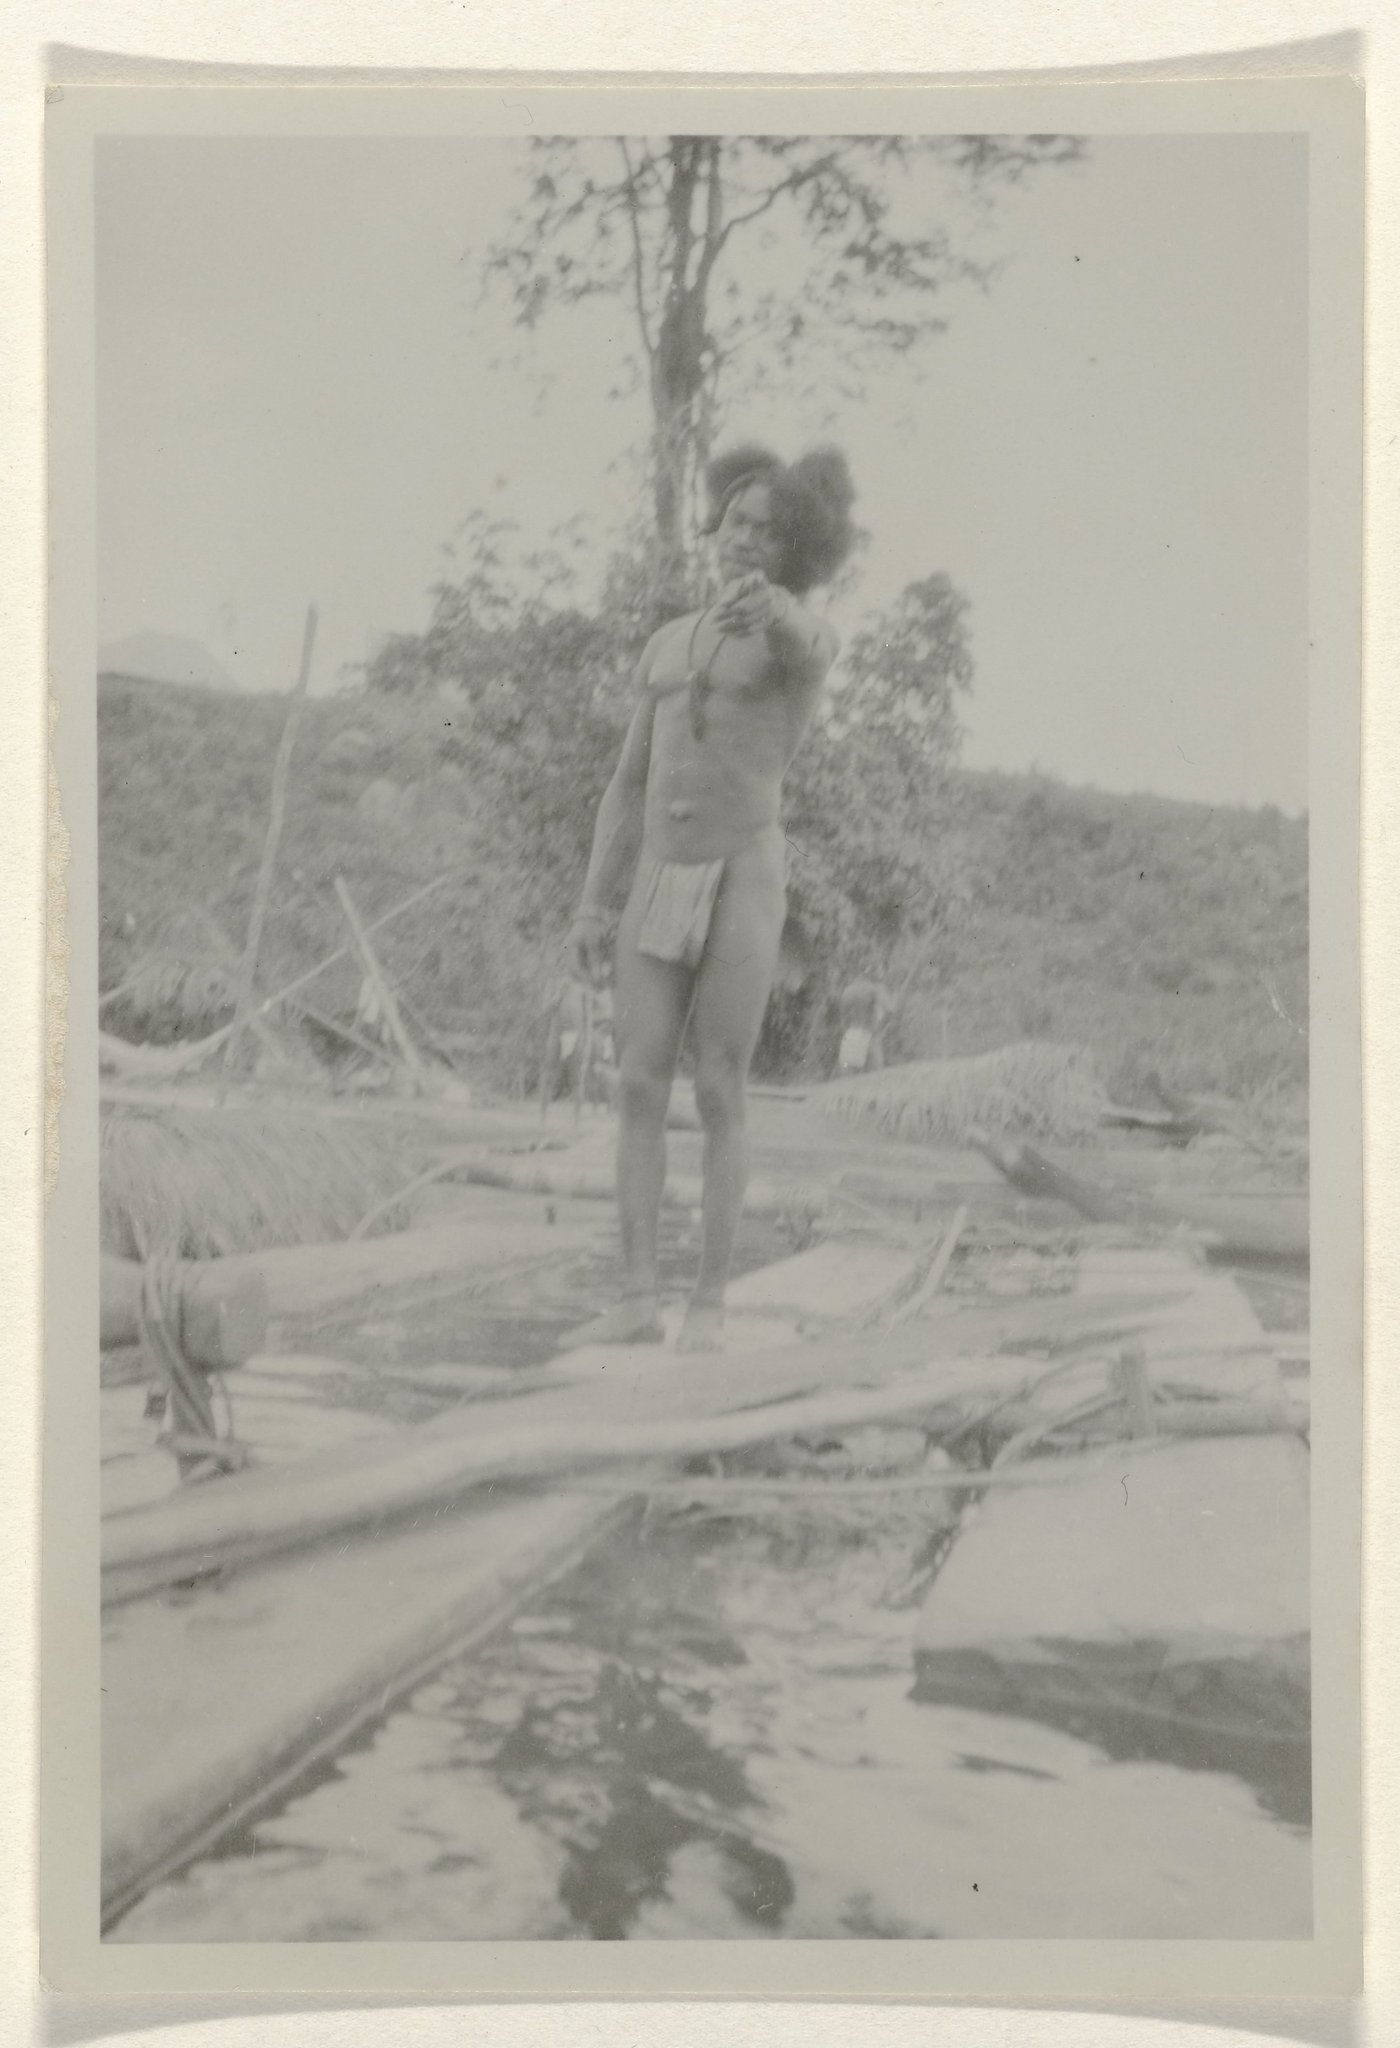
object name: photograph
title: Surinaamse man in het binnenland van Suriname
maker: Anonymous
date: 1929-1930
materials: photographic support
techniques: photography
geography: suriname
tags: albina, moengo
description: Surinaamse man in het binnenland van Suriname. Hij is schaars gekleed en wijst naar de camera.